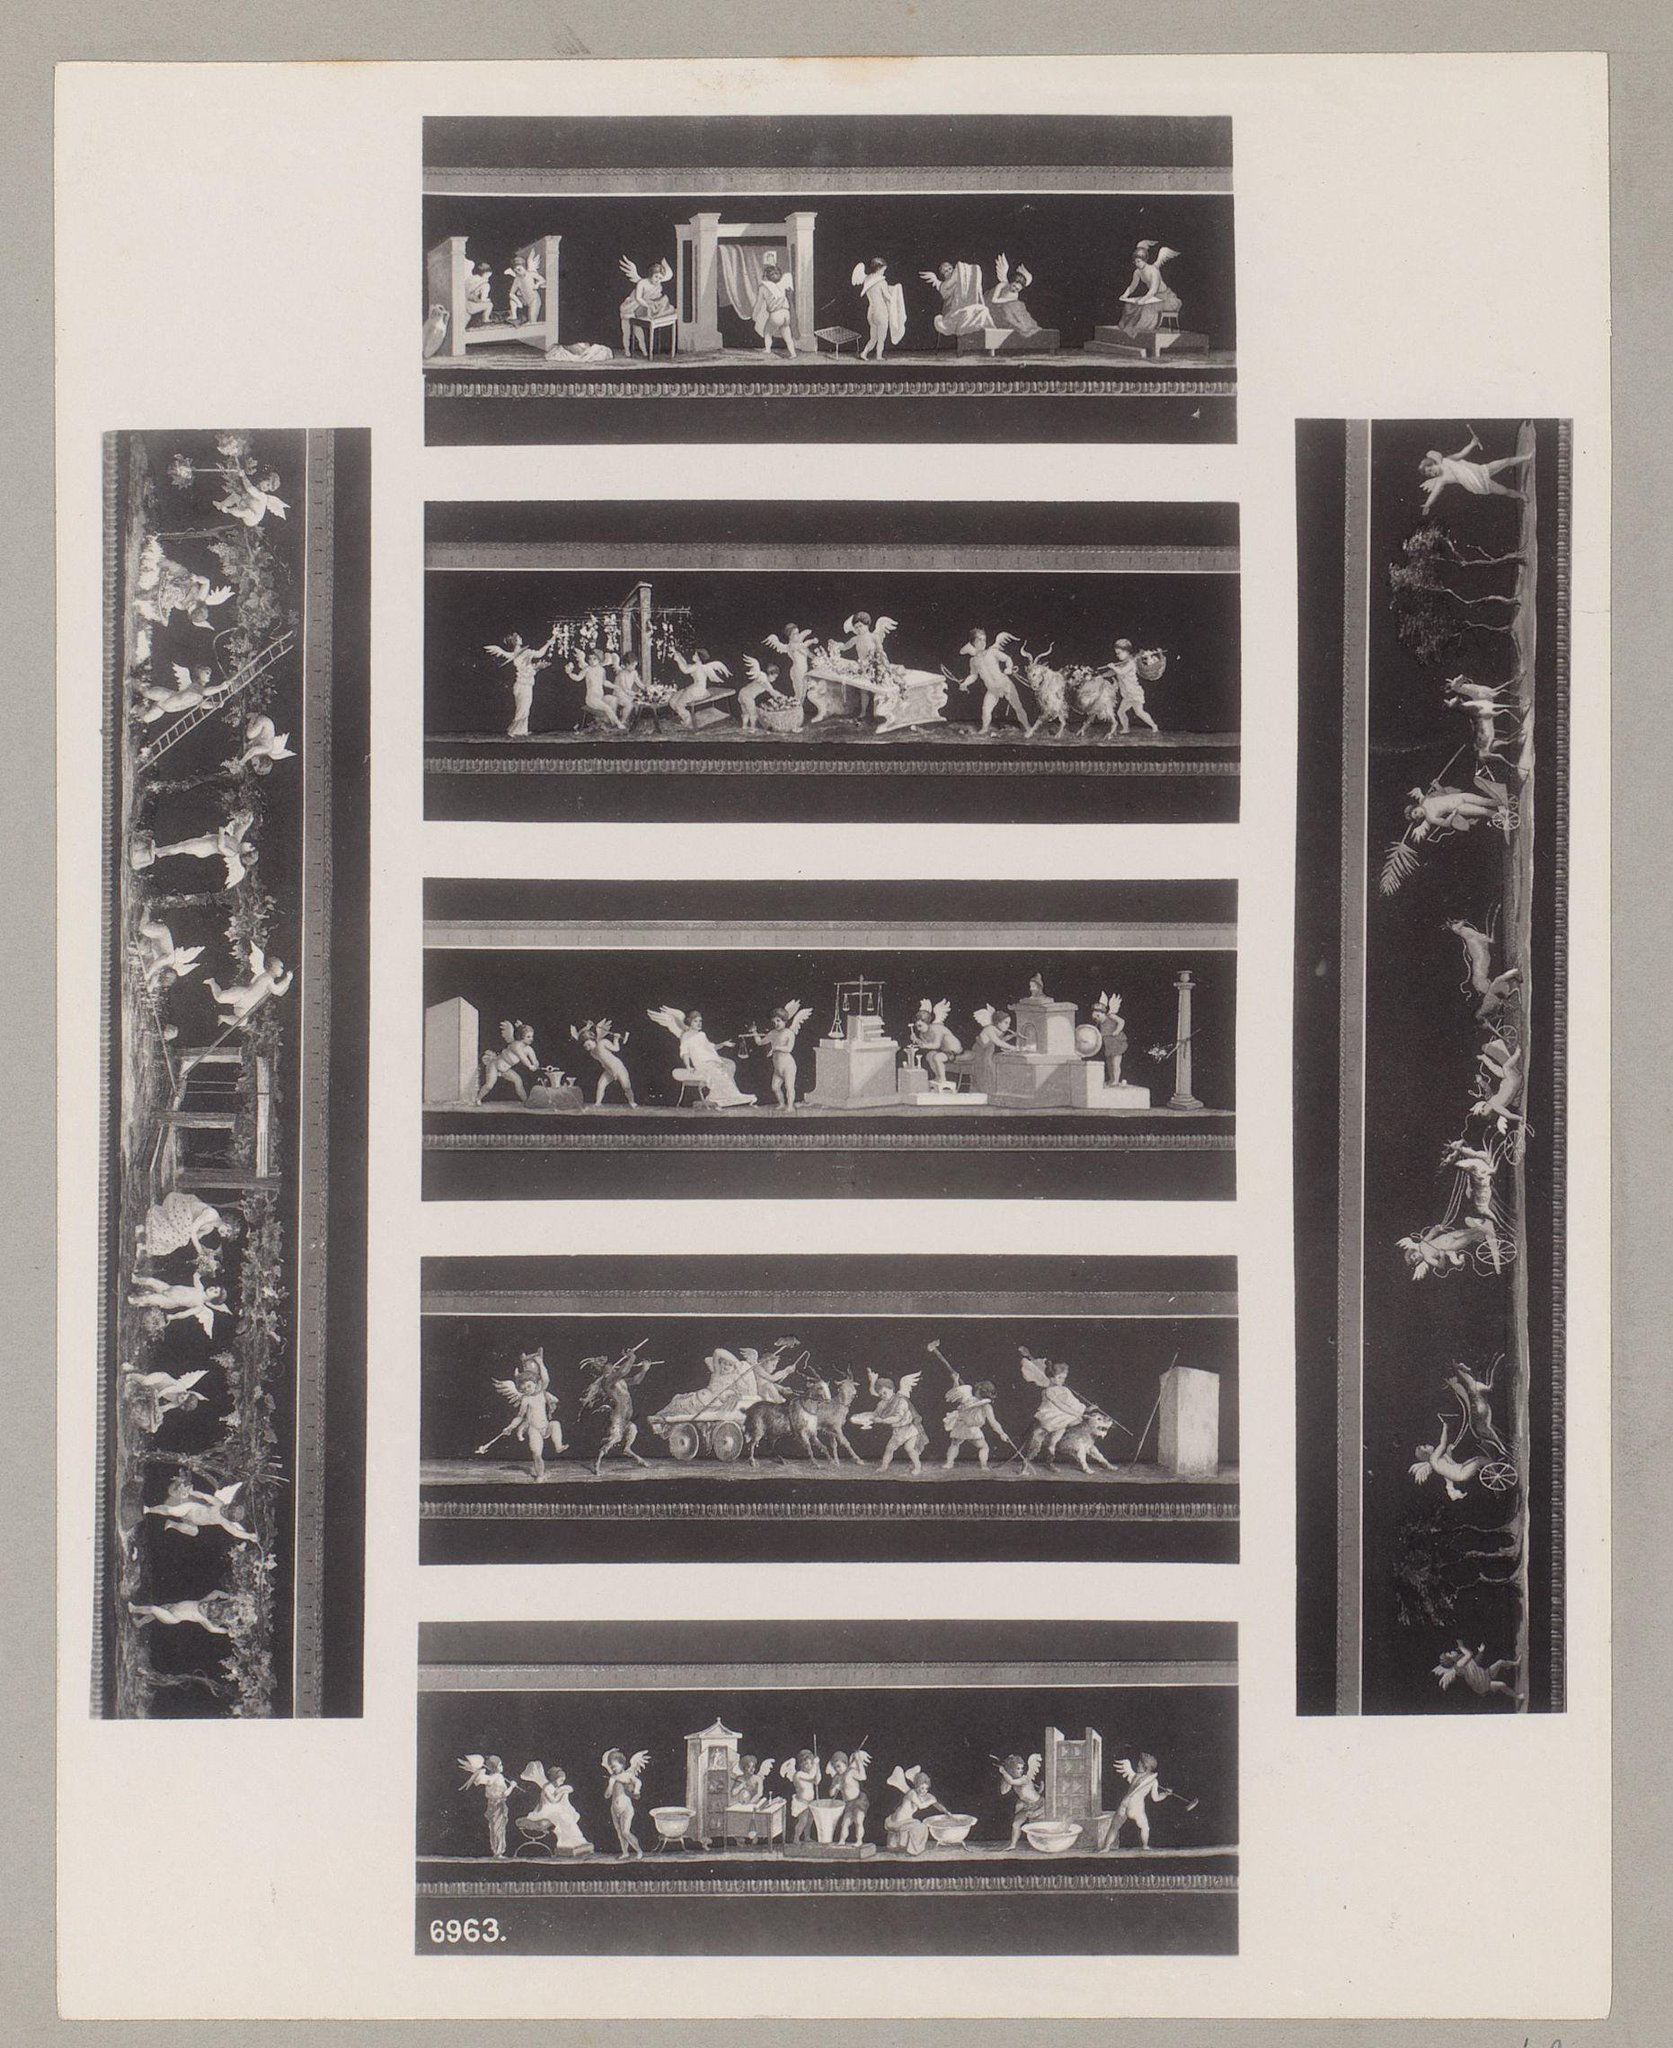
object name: photograph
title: Pompeï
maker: giorgio sommer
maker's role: fotograaf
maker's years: 1834-1914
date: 1888-1903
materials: cardboard, photographic support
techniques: albumen print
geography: naples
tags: pompeii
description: Foto van balkvormigetekeningen van engelen in dagelijkse bezigheden als het plukken van druiven en het smeden en gieten van instrumenten en andere gebruiksvoorwerpen.